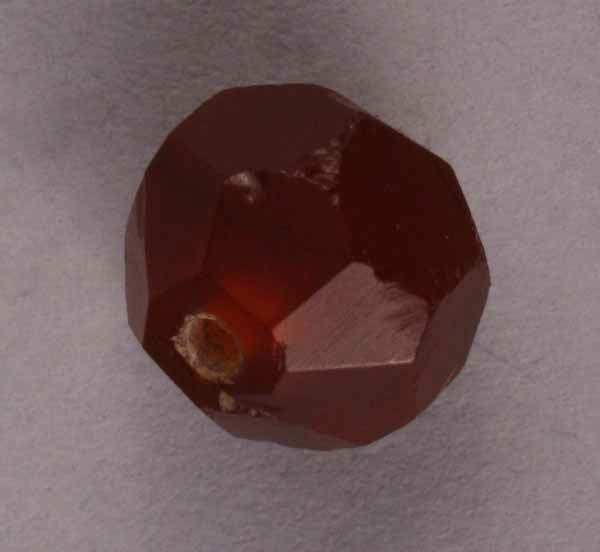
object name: bead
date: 801-1200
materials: gemstone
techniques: cutting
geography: iran